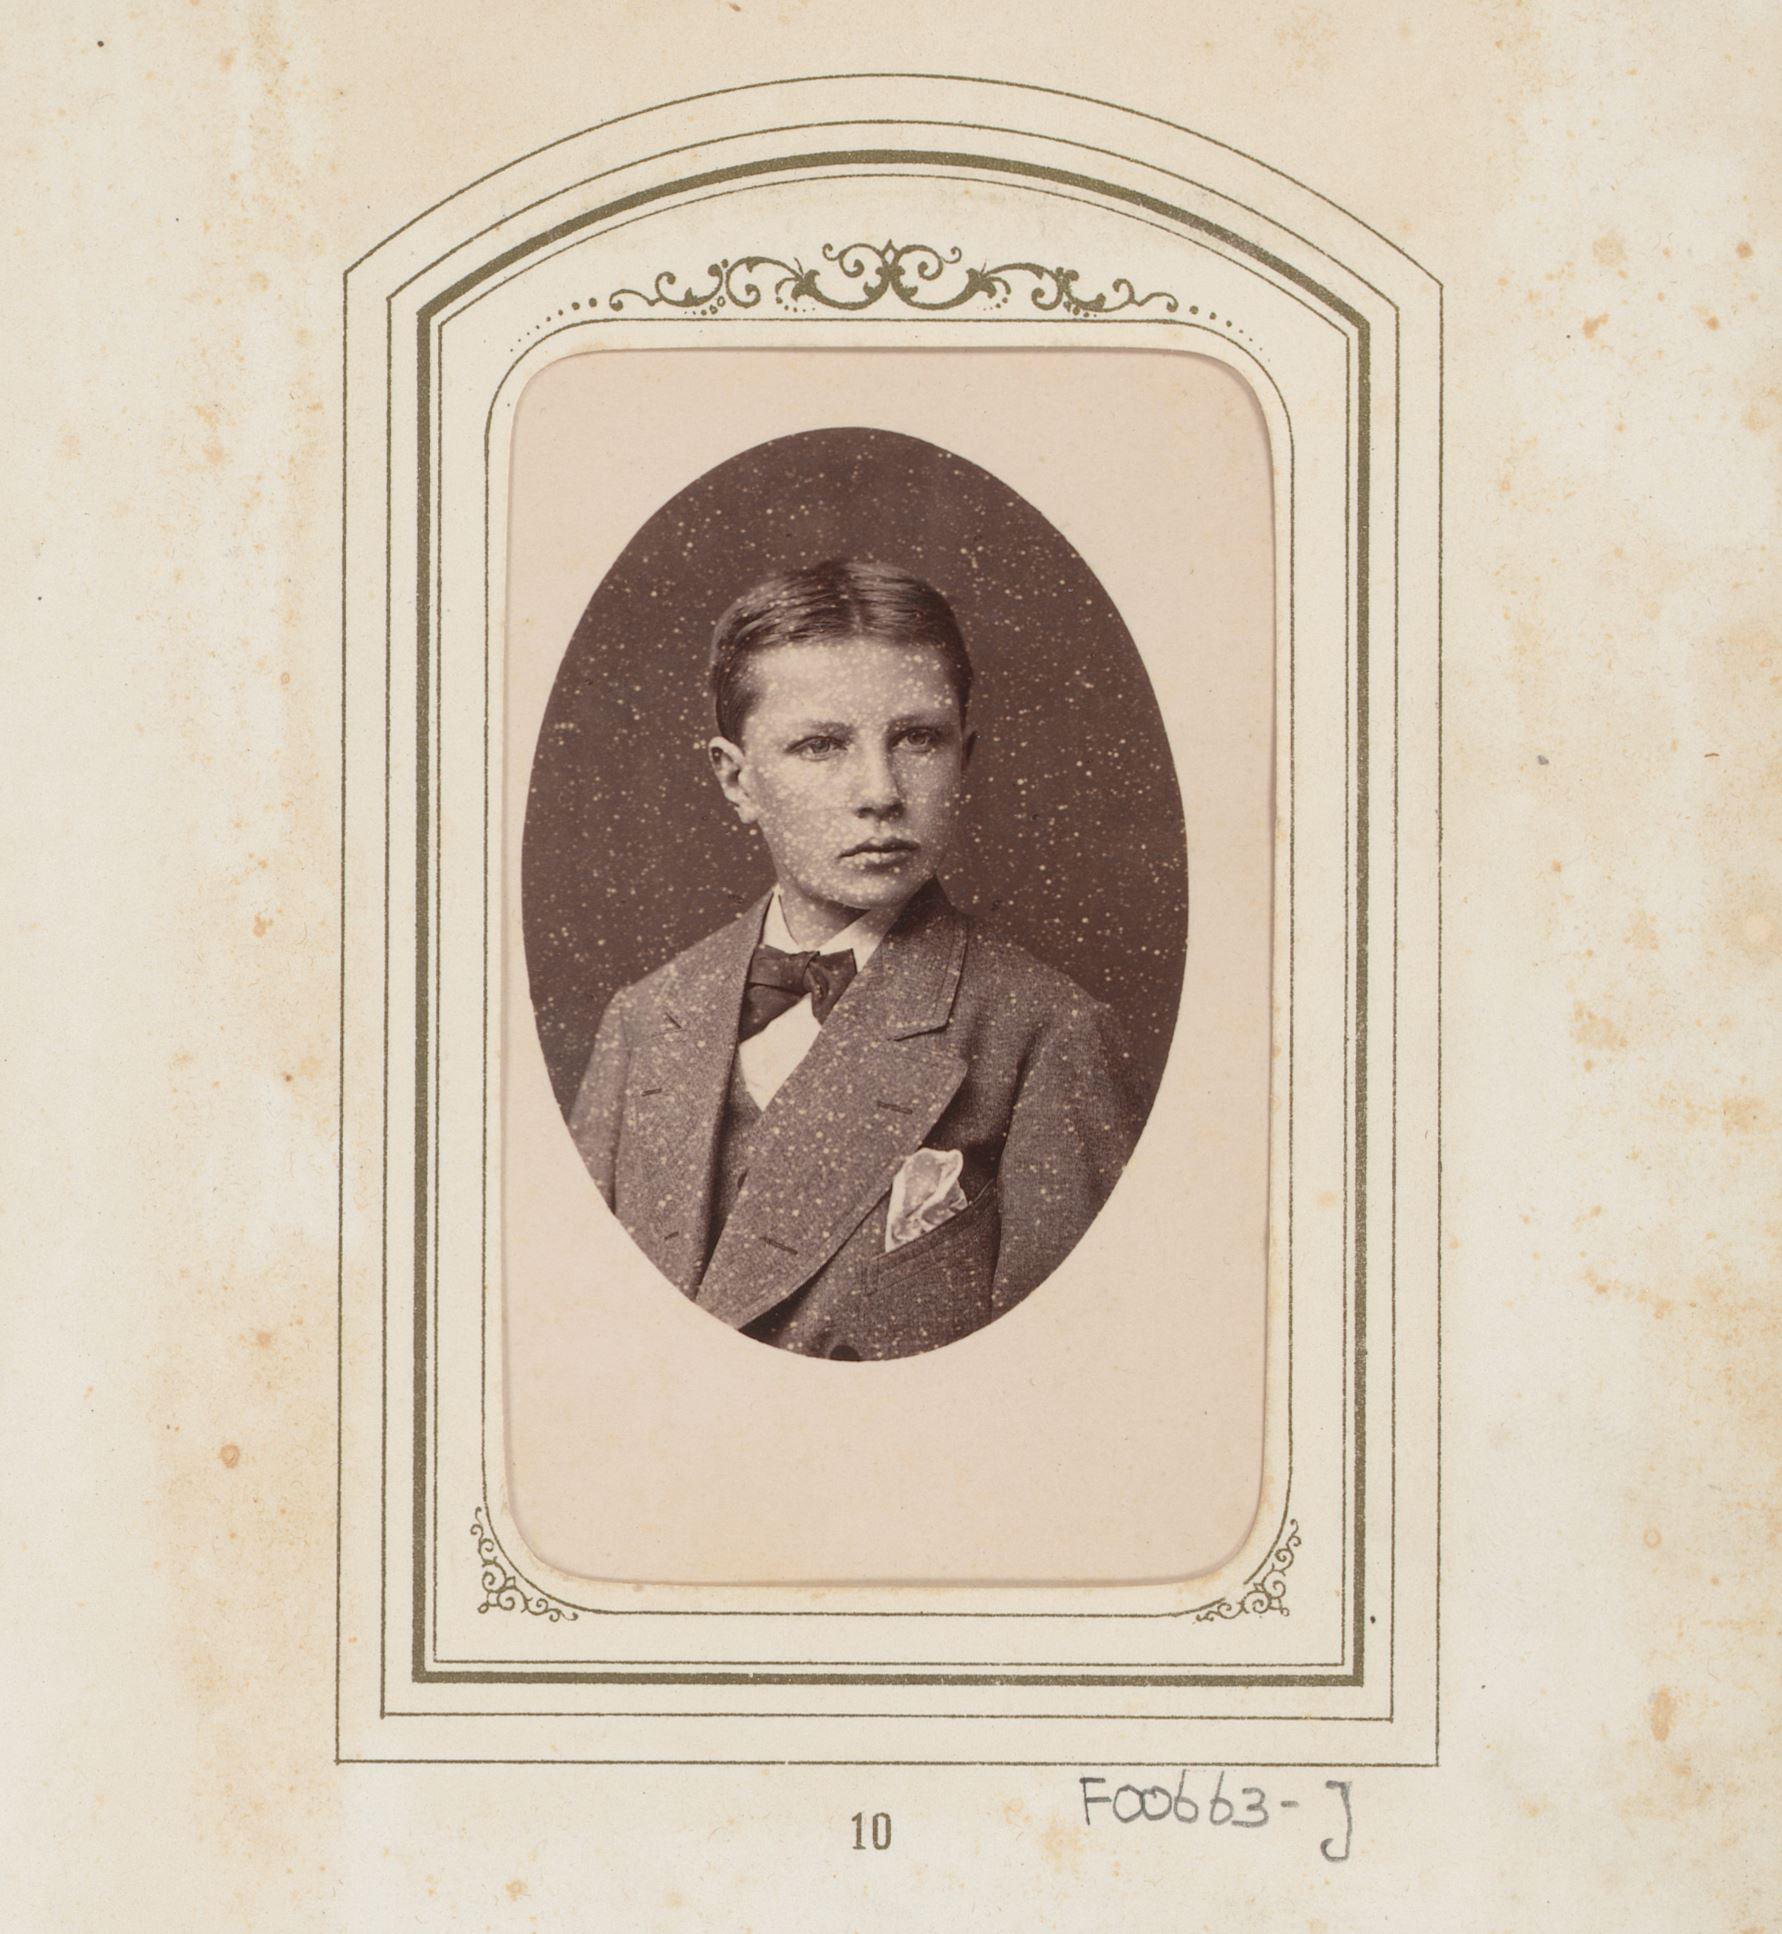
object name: photograph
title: Portret van een jongeman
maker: cornelis bernardus broersma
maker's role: fotograaf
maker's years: 1841-1919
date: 1860-1880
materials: cardboard, photographic support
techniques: albumen print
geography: leeuwarden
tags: historical persons, youth, adolescent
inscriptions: number: ‘10’, inscription: ‘C.B. Broersma/ Photographische Kunstinrichting/ Vleeschmarkt/ Letter F No. 8/ Leeuwarden (...)’